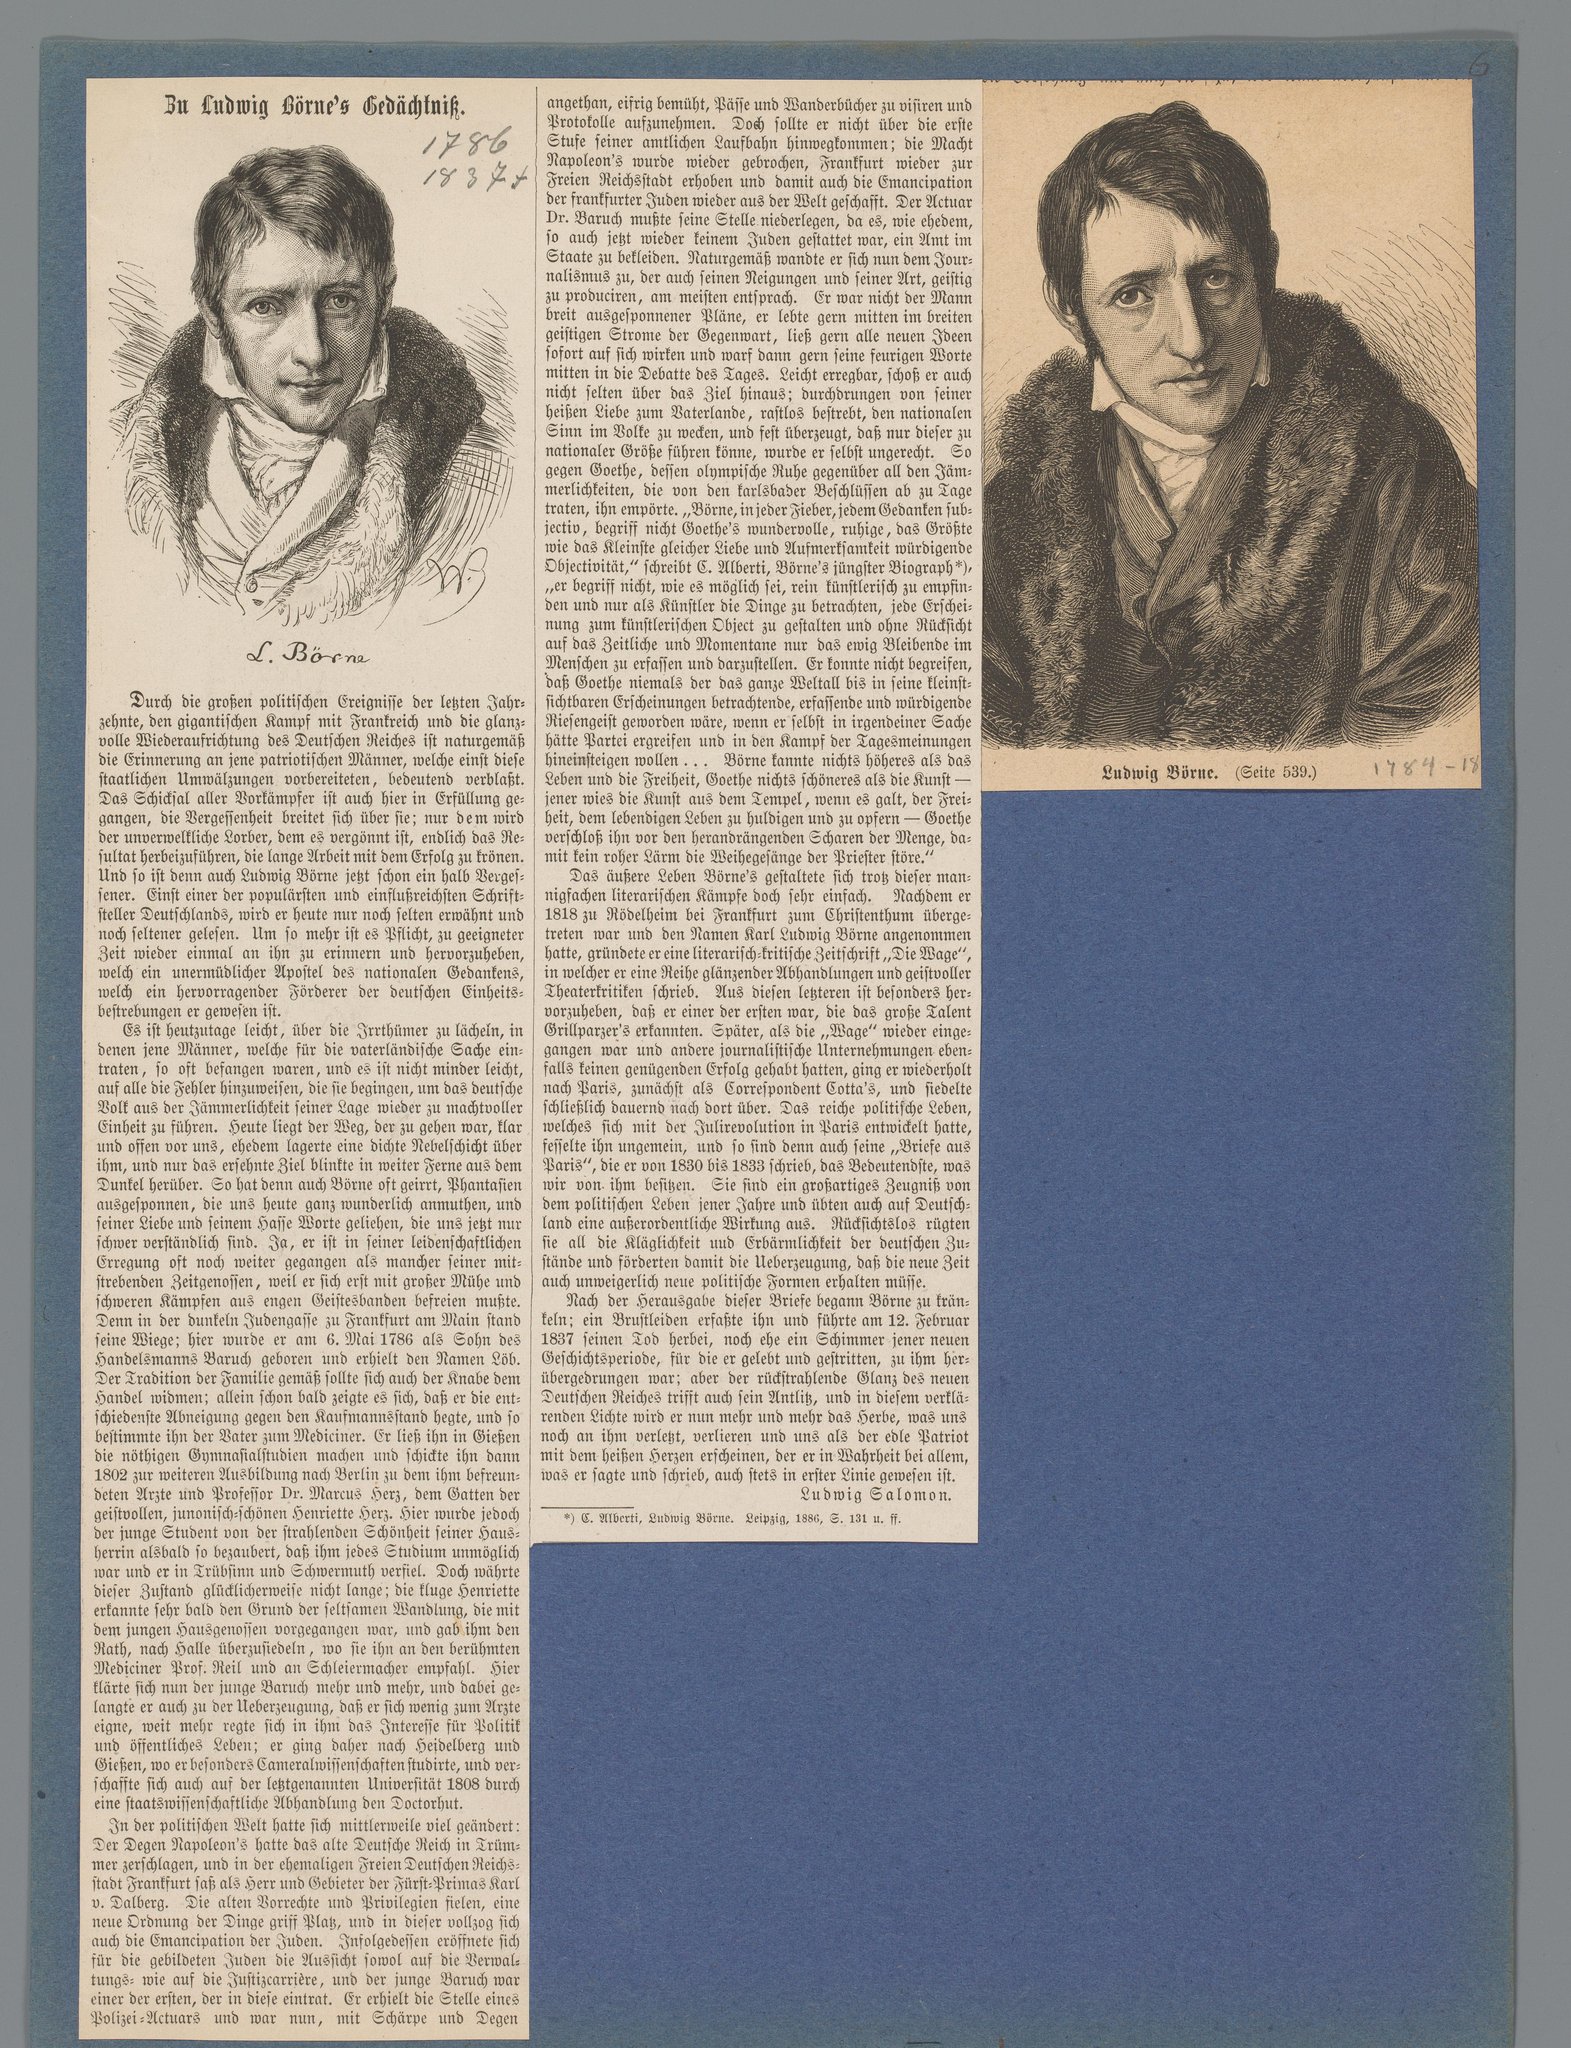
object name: sheet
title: Blad met twee portretten van Ludwig Börne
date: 1850-1900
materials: paper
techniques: letterpress printing, snipping, engraving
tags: paris, journalist, reporter, historical persons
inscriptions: number: ‘6’, signature: ‘W.’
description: Met facsimile handtekening van de geportretteerde.